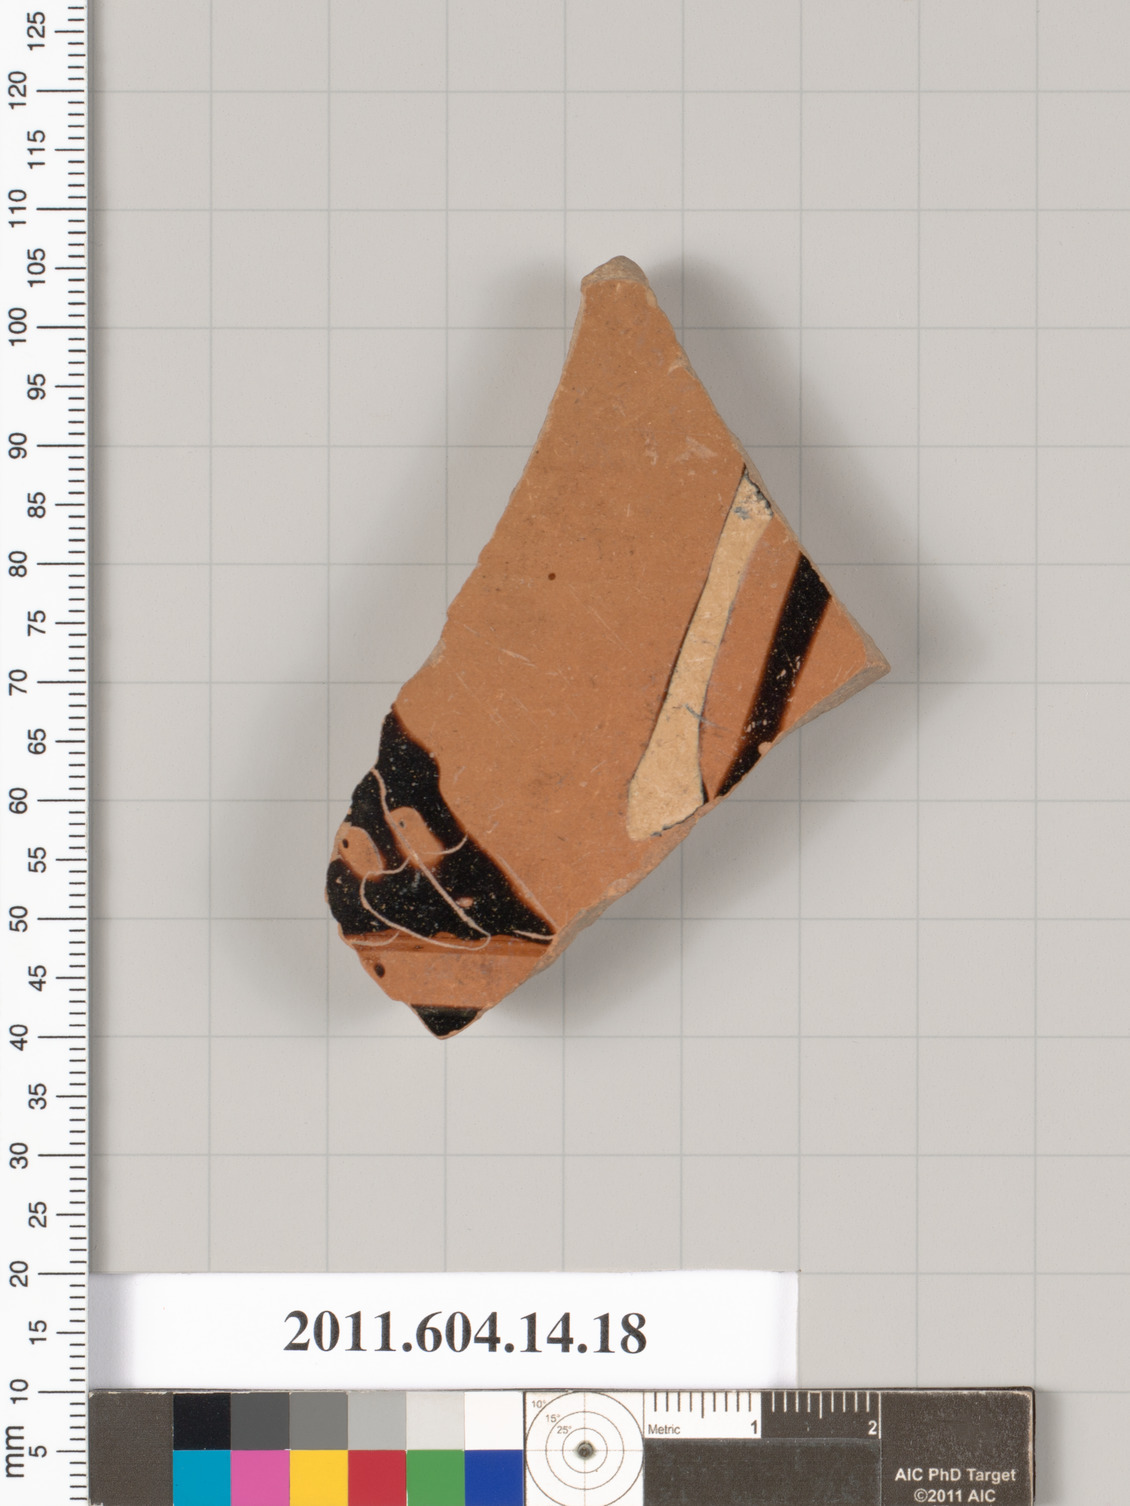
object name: krater fragment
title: Terracotta fragment of a krater?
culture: unknown fabric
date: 600-501 BCE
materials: terracotta